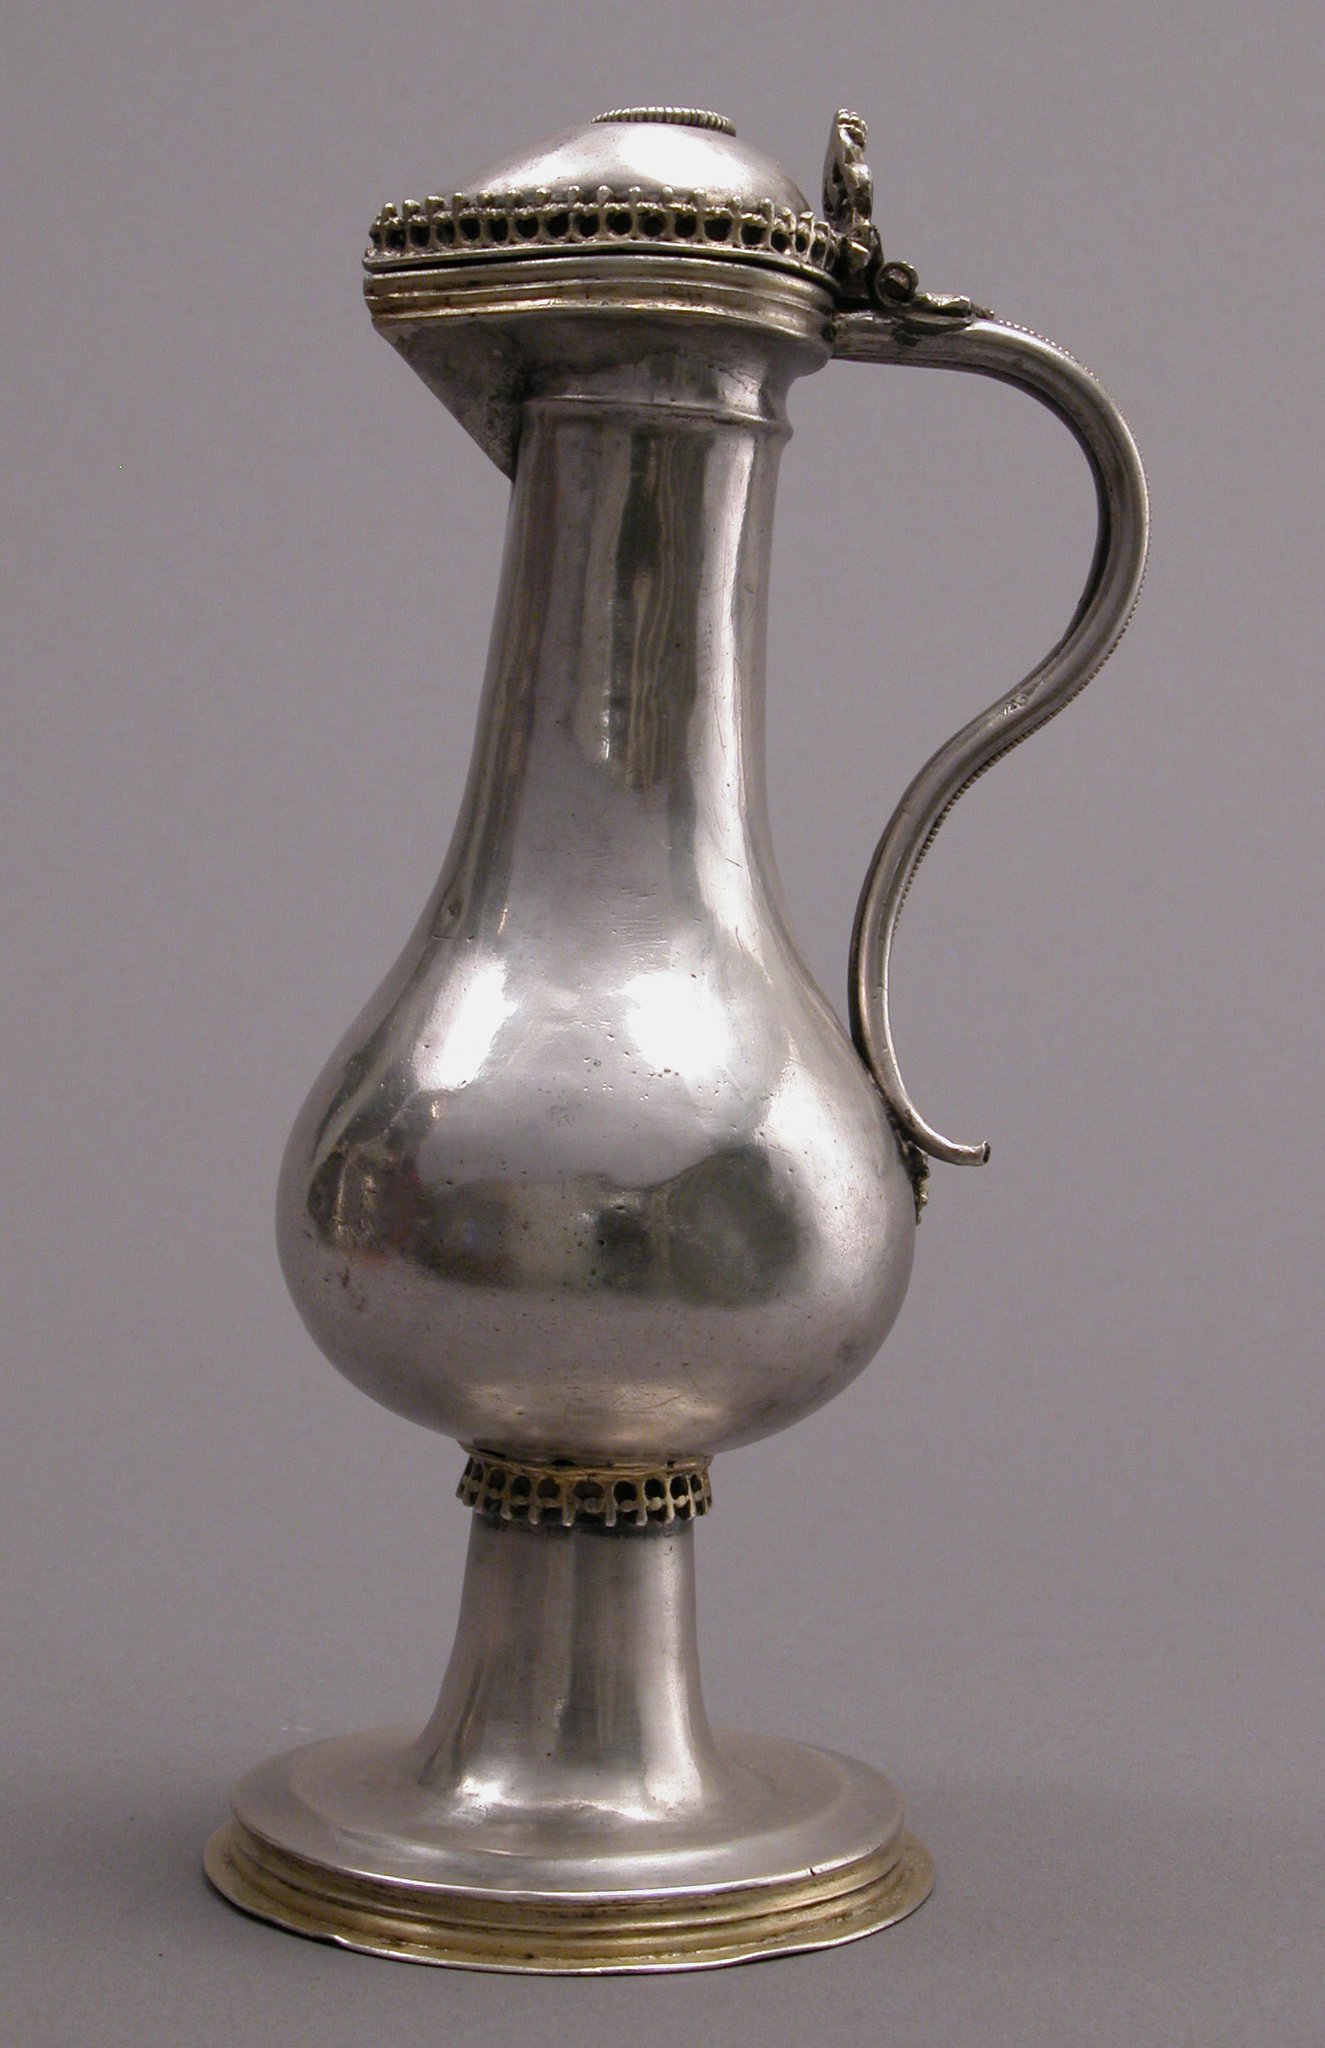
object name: cruet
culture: german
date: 1518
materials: silver, silver gilt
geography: germany